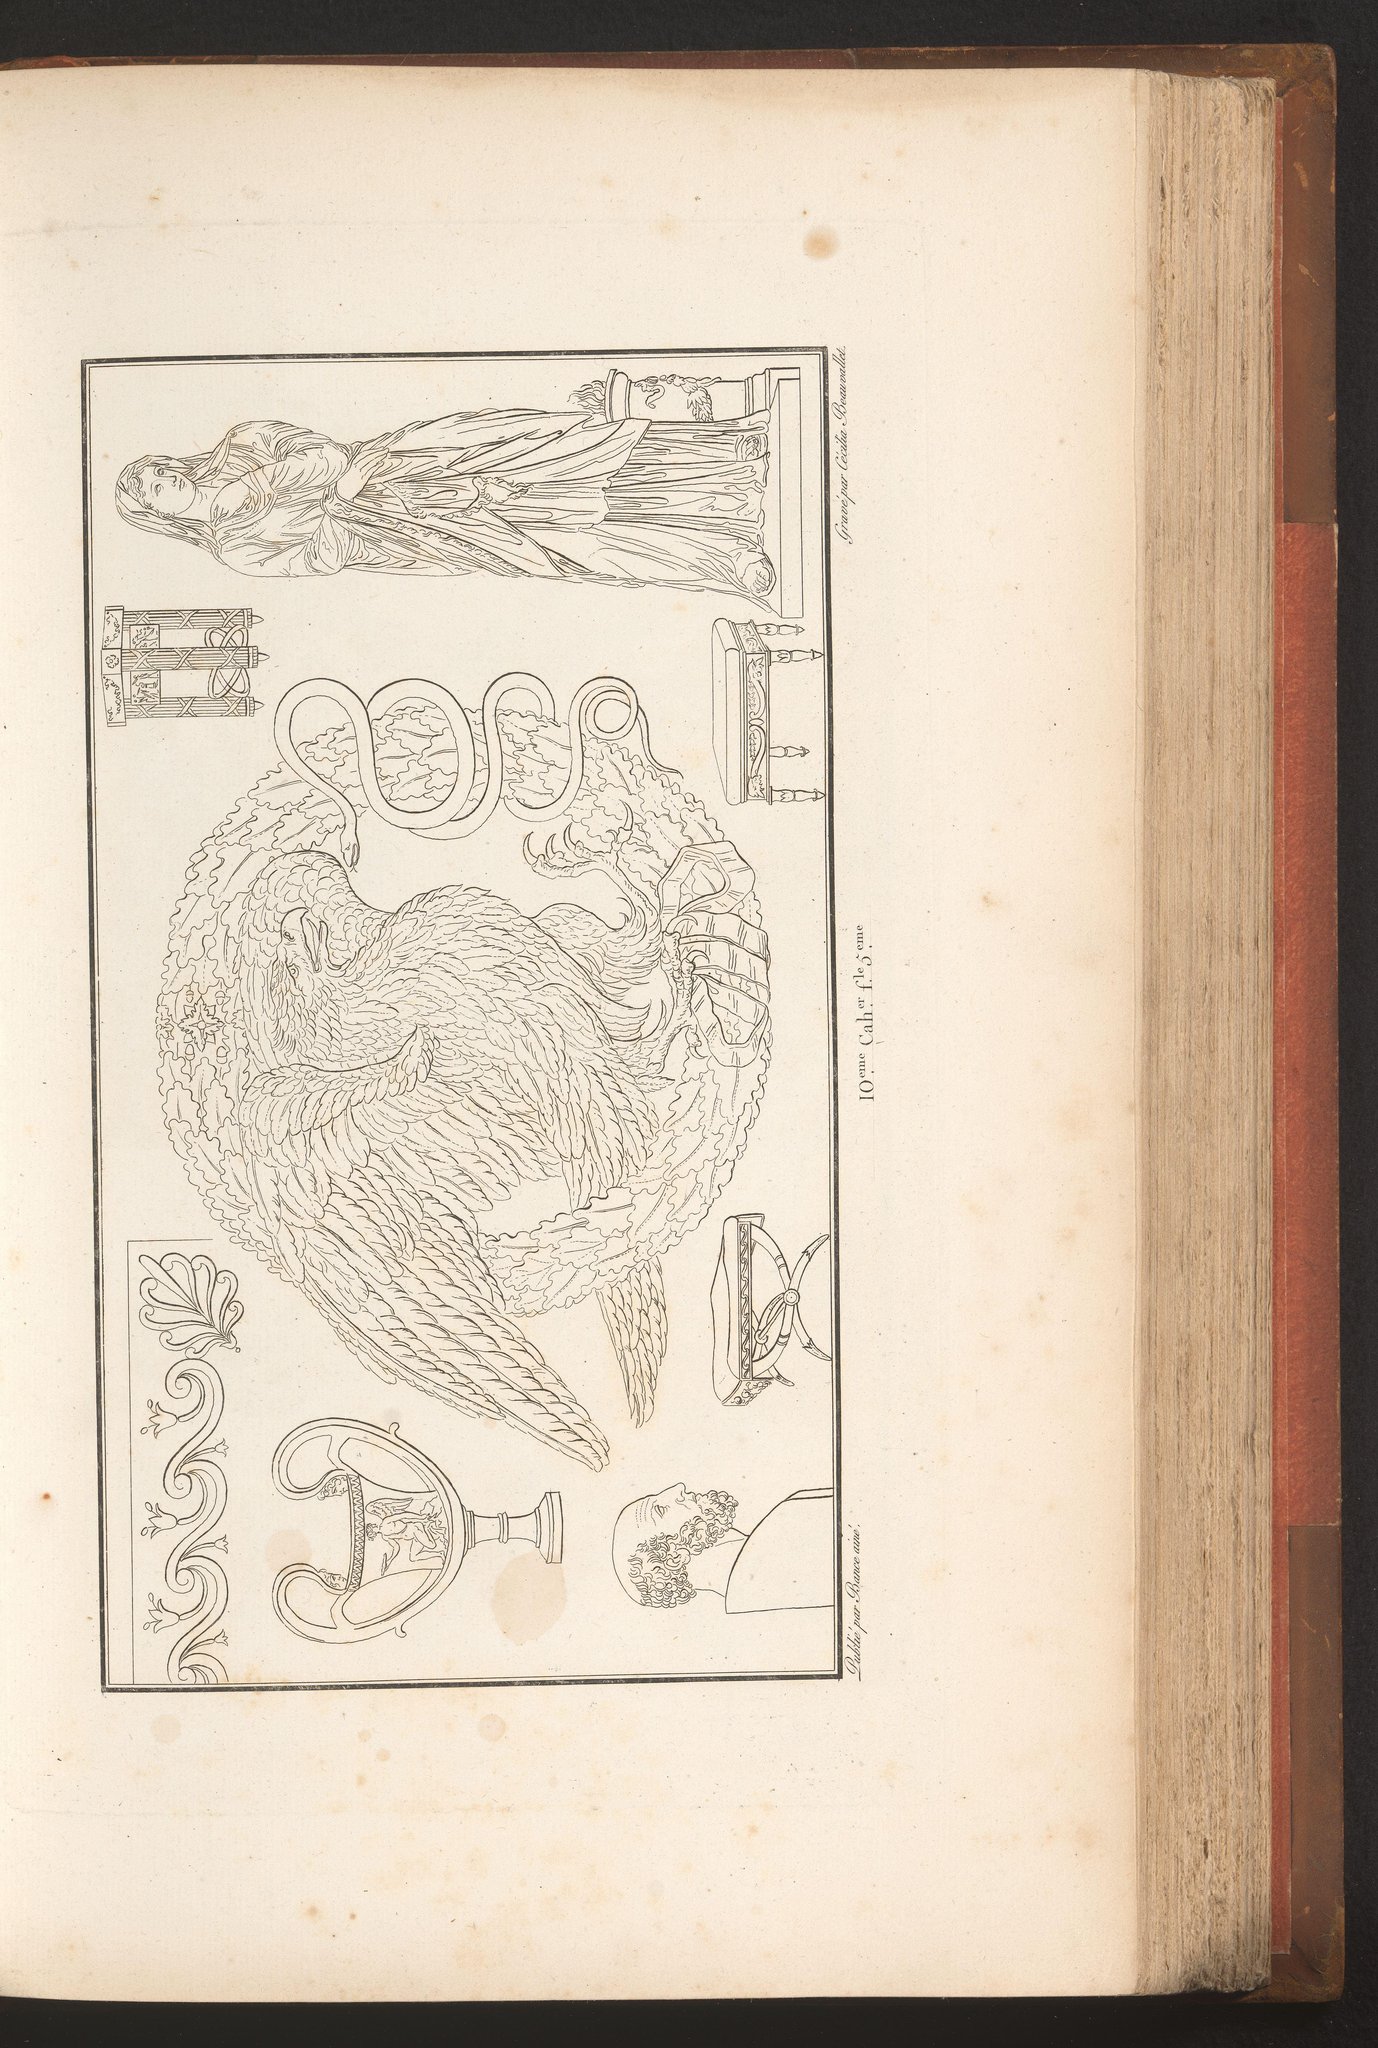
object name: ornament print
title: Diverse ornamenten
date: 1820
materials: paper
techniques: etching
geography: paris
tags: ornaments ~ art, predatory birds: eagle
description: Ornamentprent met centraal een adelaar en een slang in een eikenkrans. Onderdeel (10e. Cah. f.le 5) van het prentalbum met twee series van in totaal 138 ornamentprenten door Beauvallet en Normand, 'Fragmens d'Ornemens dans le Style Antique'.